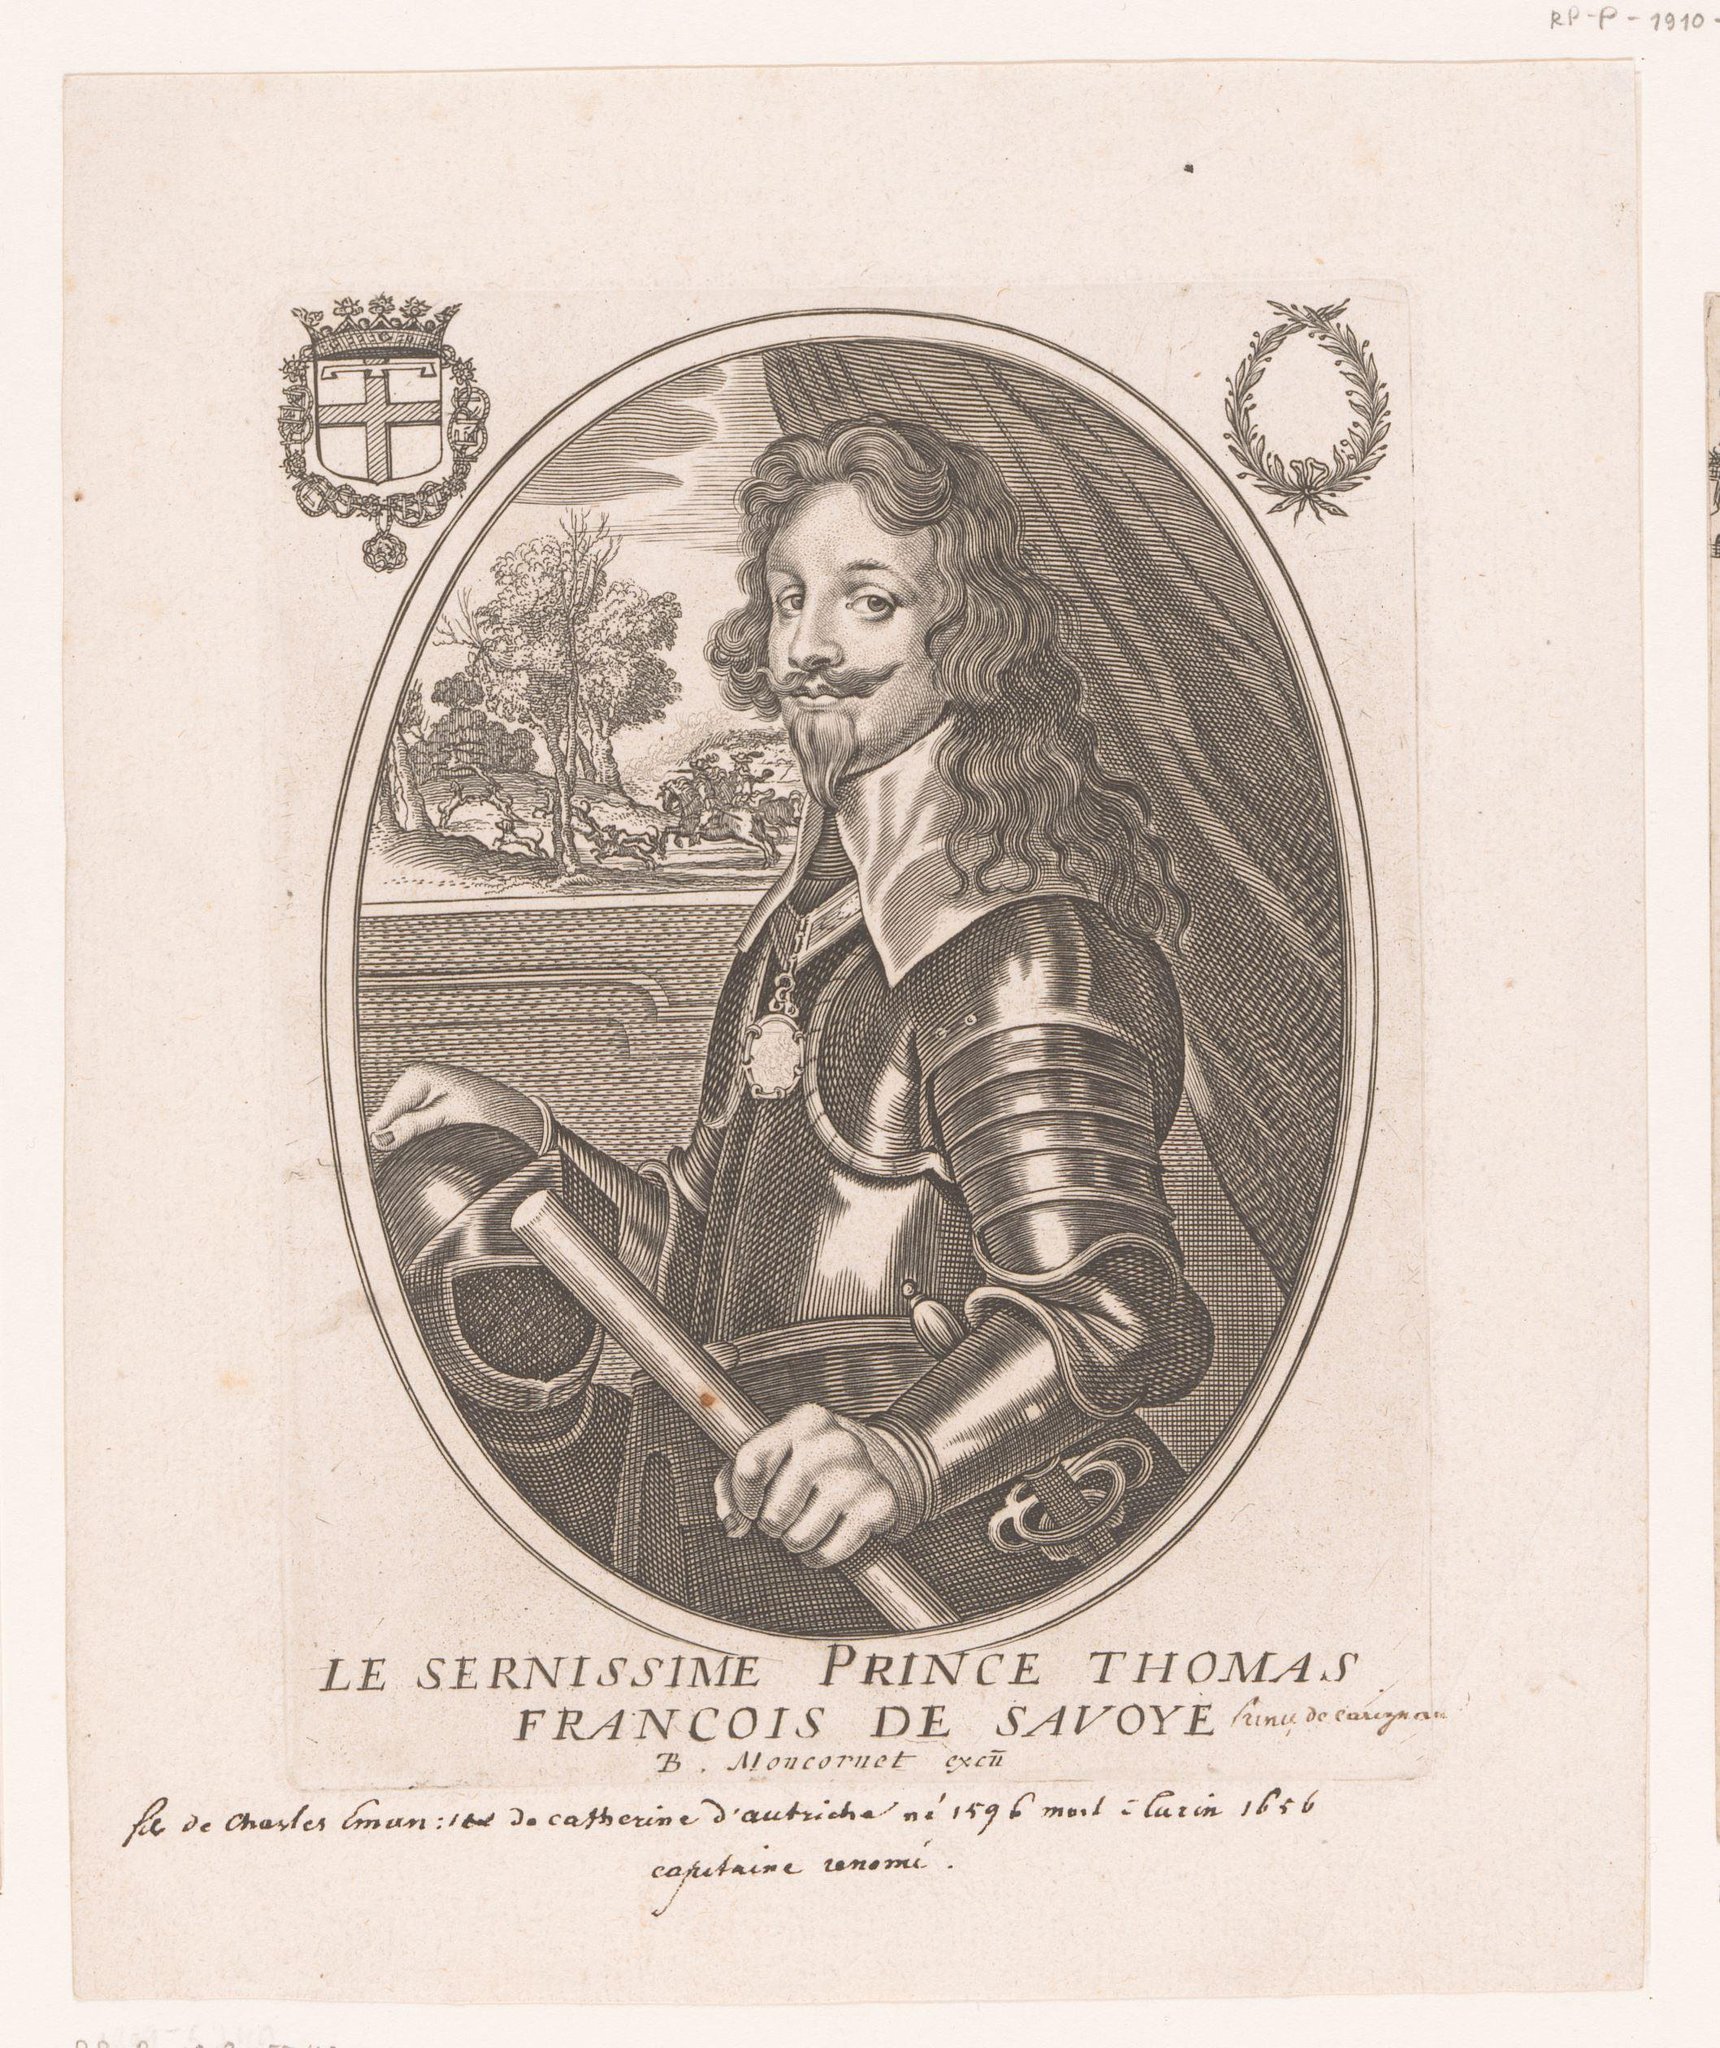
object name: print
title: Portret van Thomas Frans van Savoye-Carignano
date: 1616-1668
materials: paper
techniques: engraving, etching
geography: paris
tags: historical persons, armorial bearing, heraldry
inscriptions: collector's mark: Lugt 2228